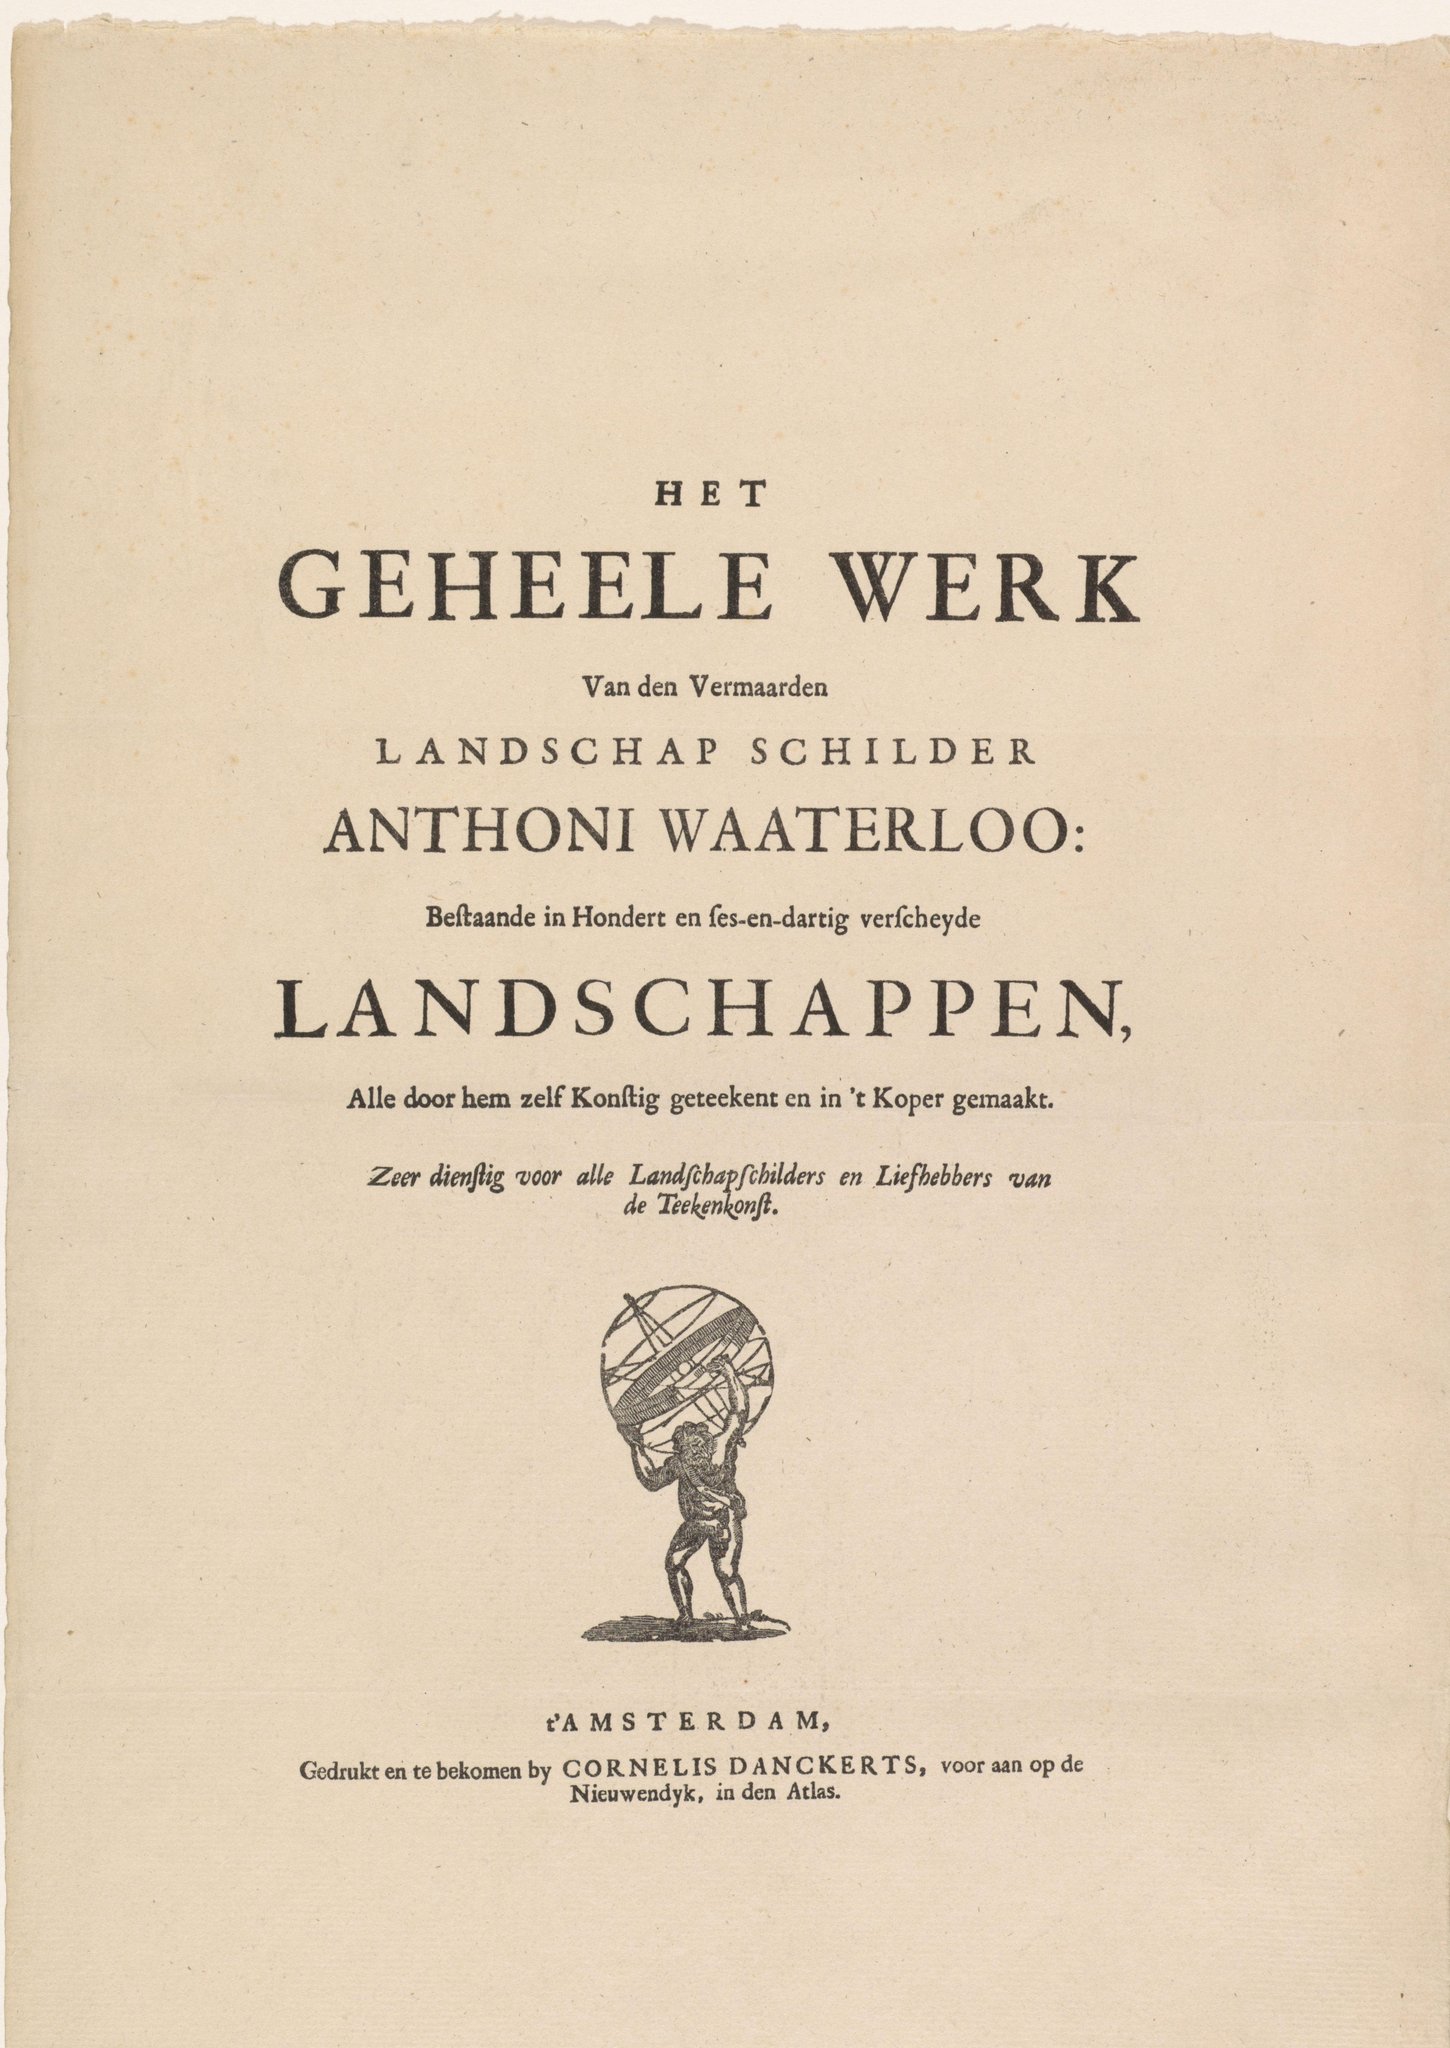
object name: titelblad, titelpagina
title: Atlas met de wereld op zijn rug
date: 1696-1717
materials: paper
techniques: lithograph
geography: amsterdam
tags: (story of) atlas, title-page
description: Titelpagina voor: Het geheele werk van den vermaarden landschap schilder Anthoni Waaterloo (...), Amsterdam: Cornelis Dankcerts, s.a. Vgl. RP-P-1879-A-3575 en RP-P-1977-56.